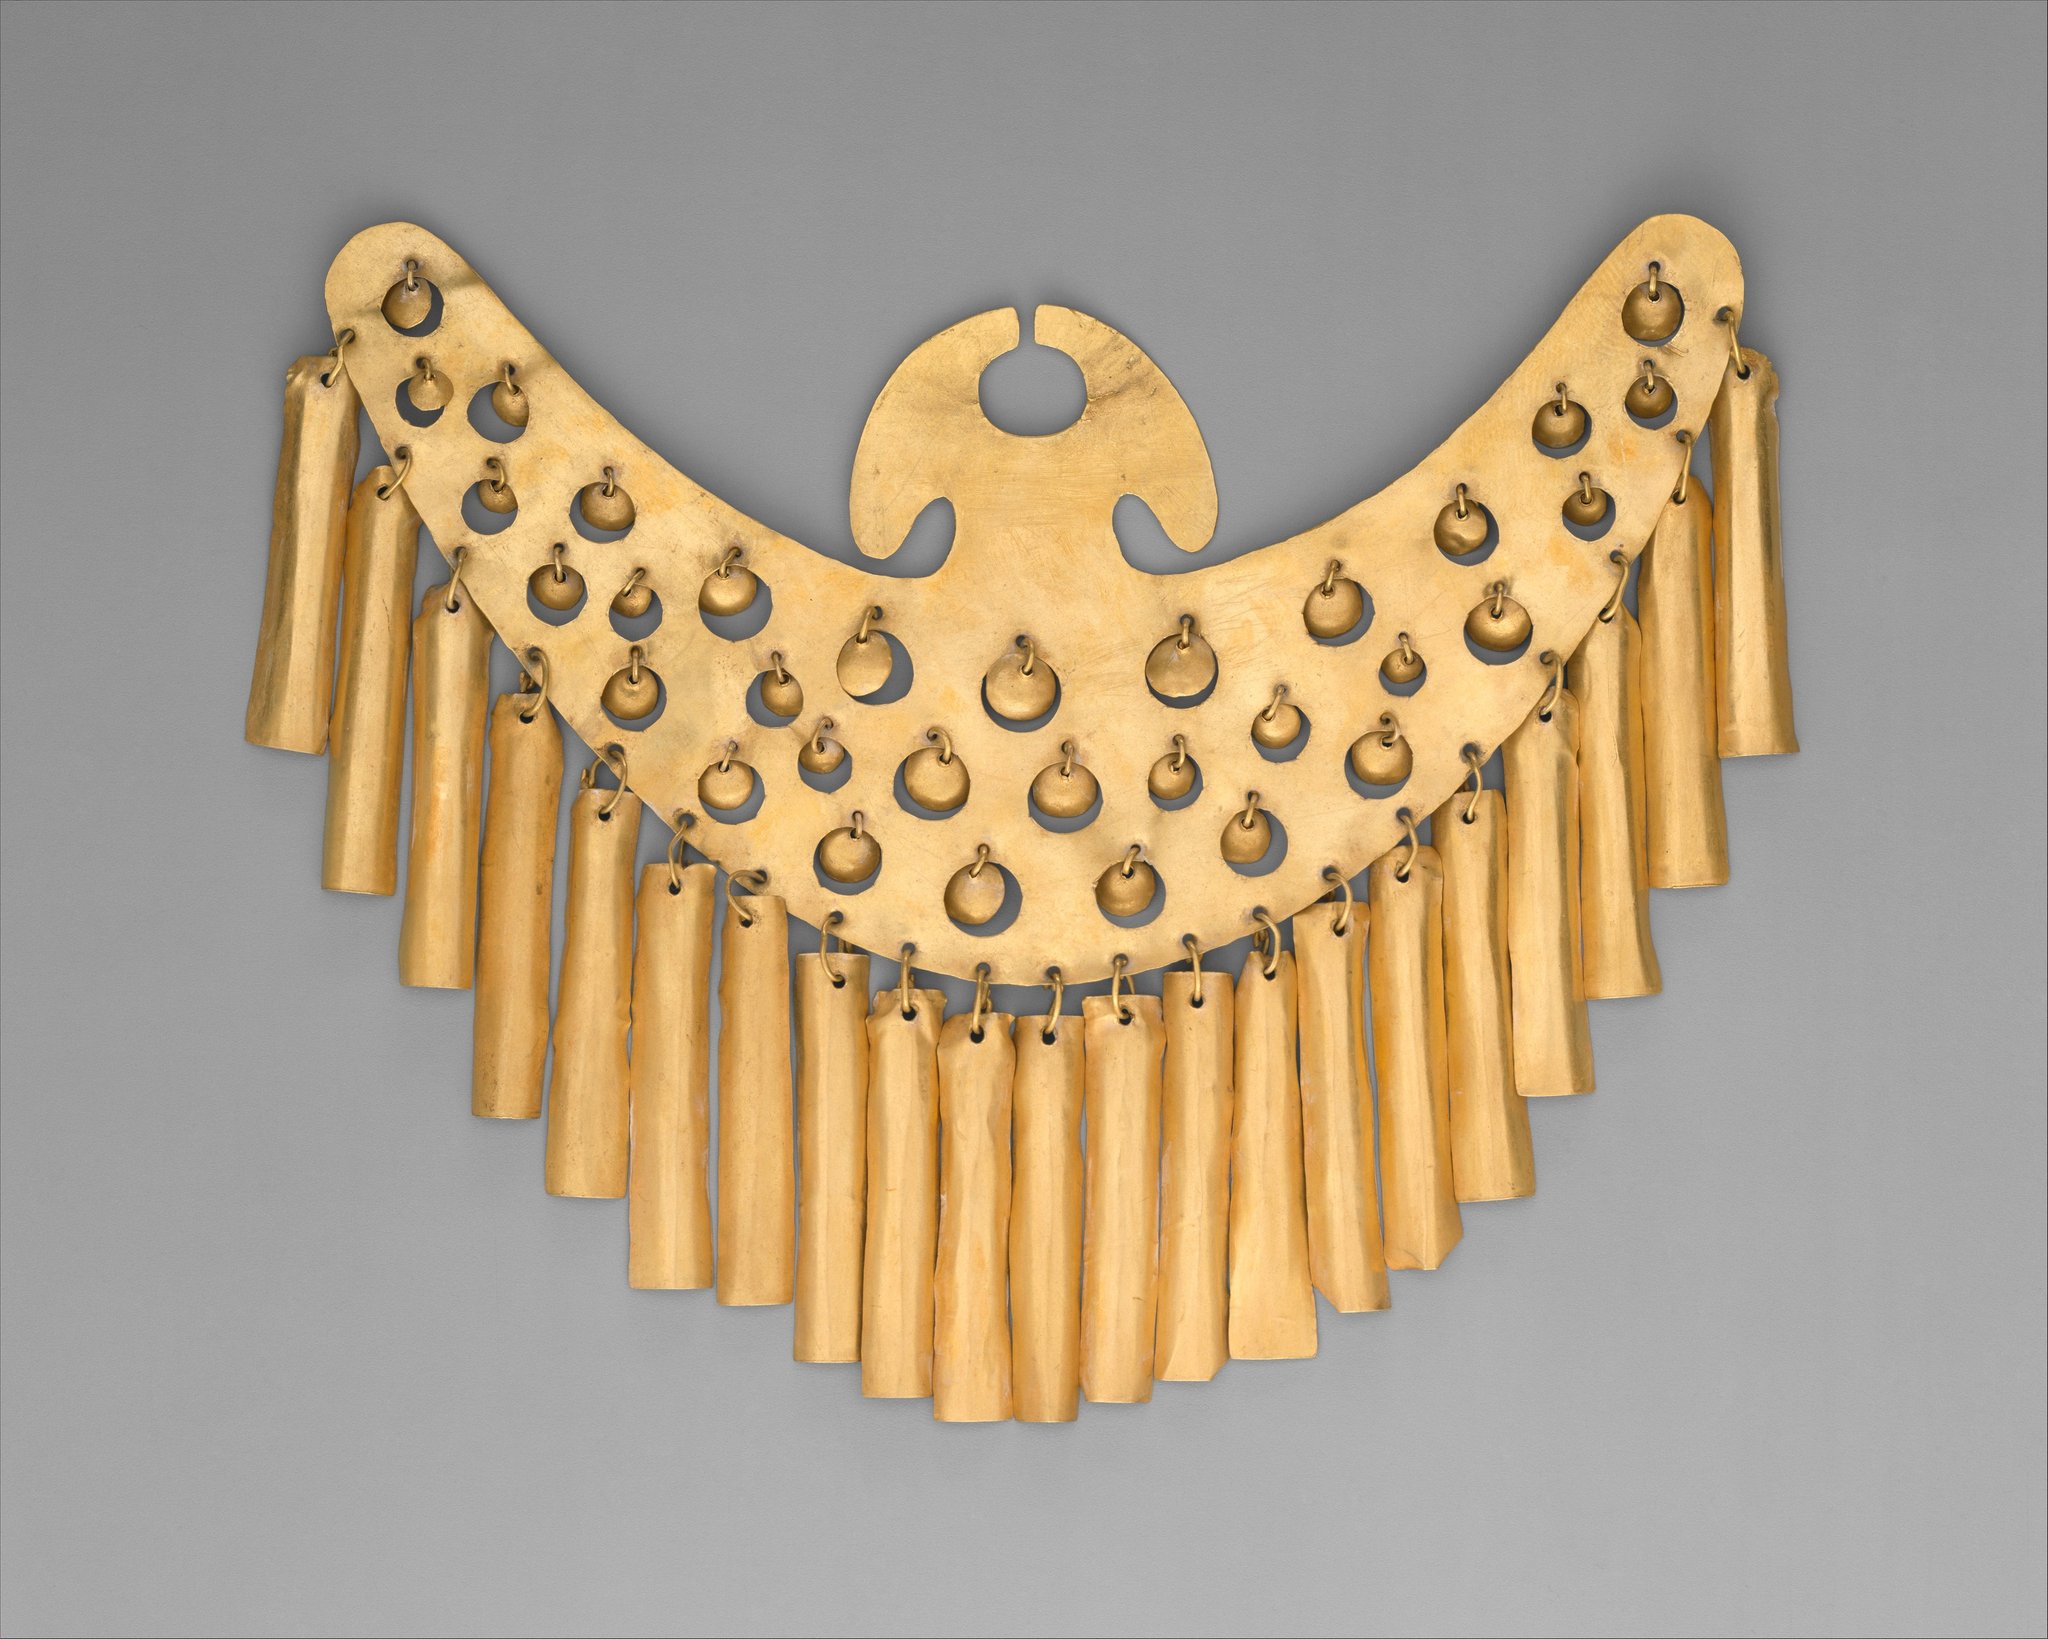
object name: nose ornament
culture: calima or yotoco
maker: calima (yotoco) artist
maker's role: artist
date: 100-700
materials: gold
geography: colombia